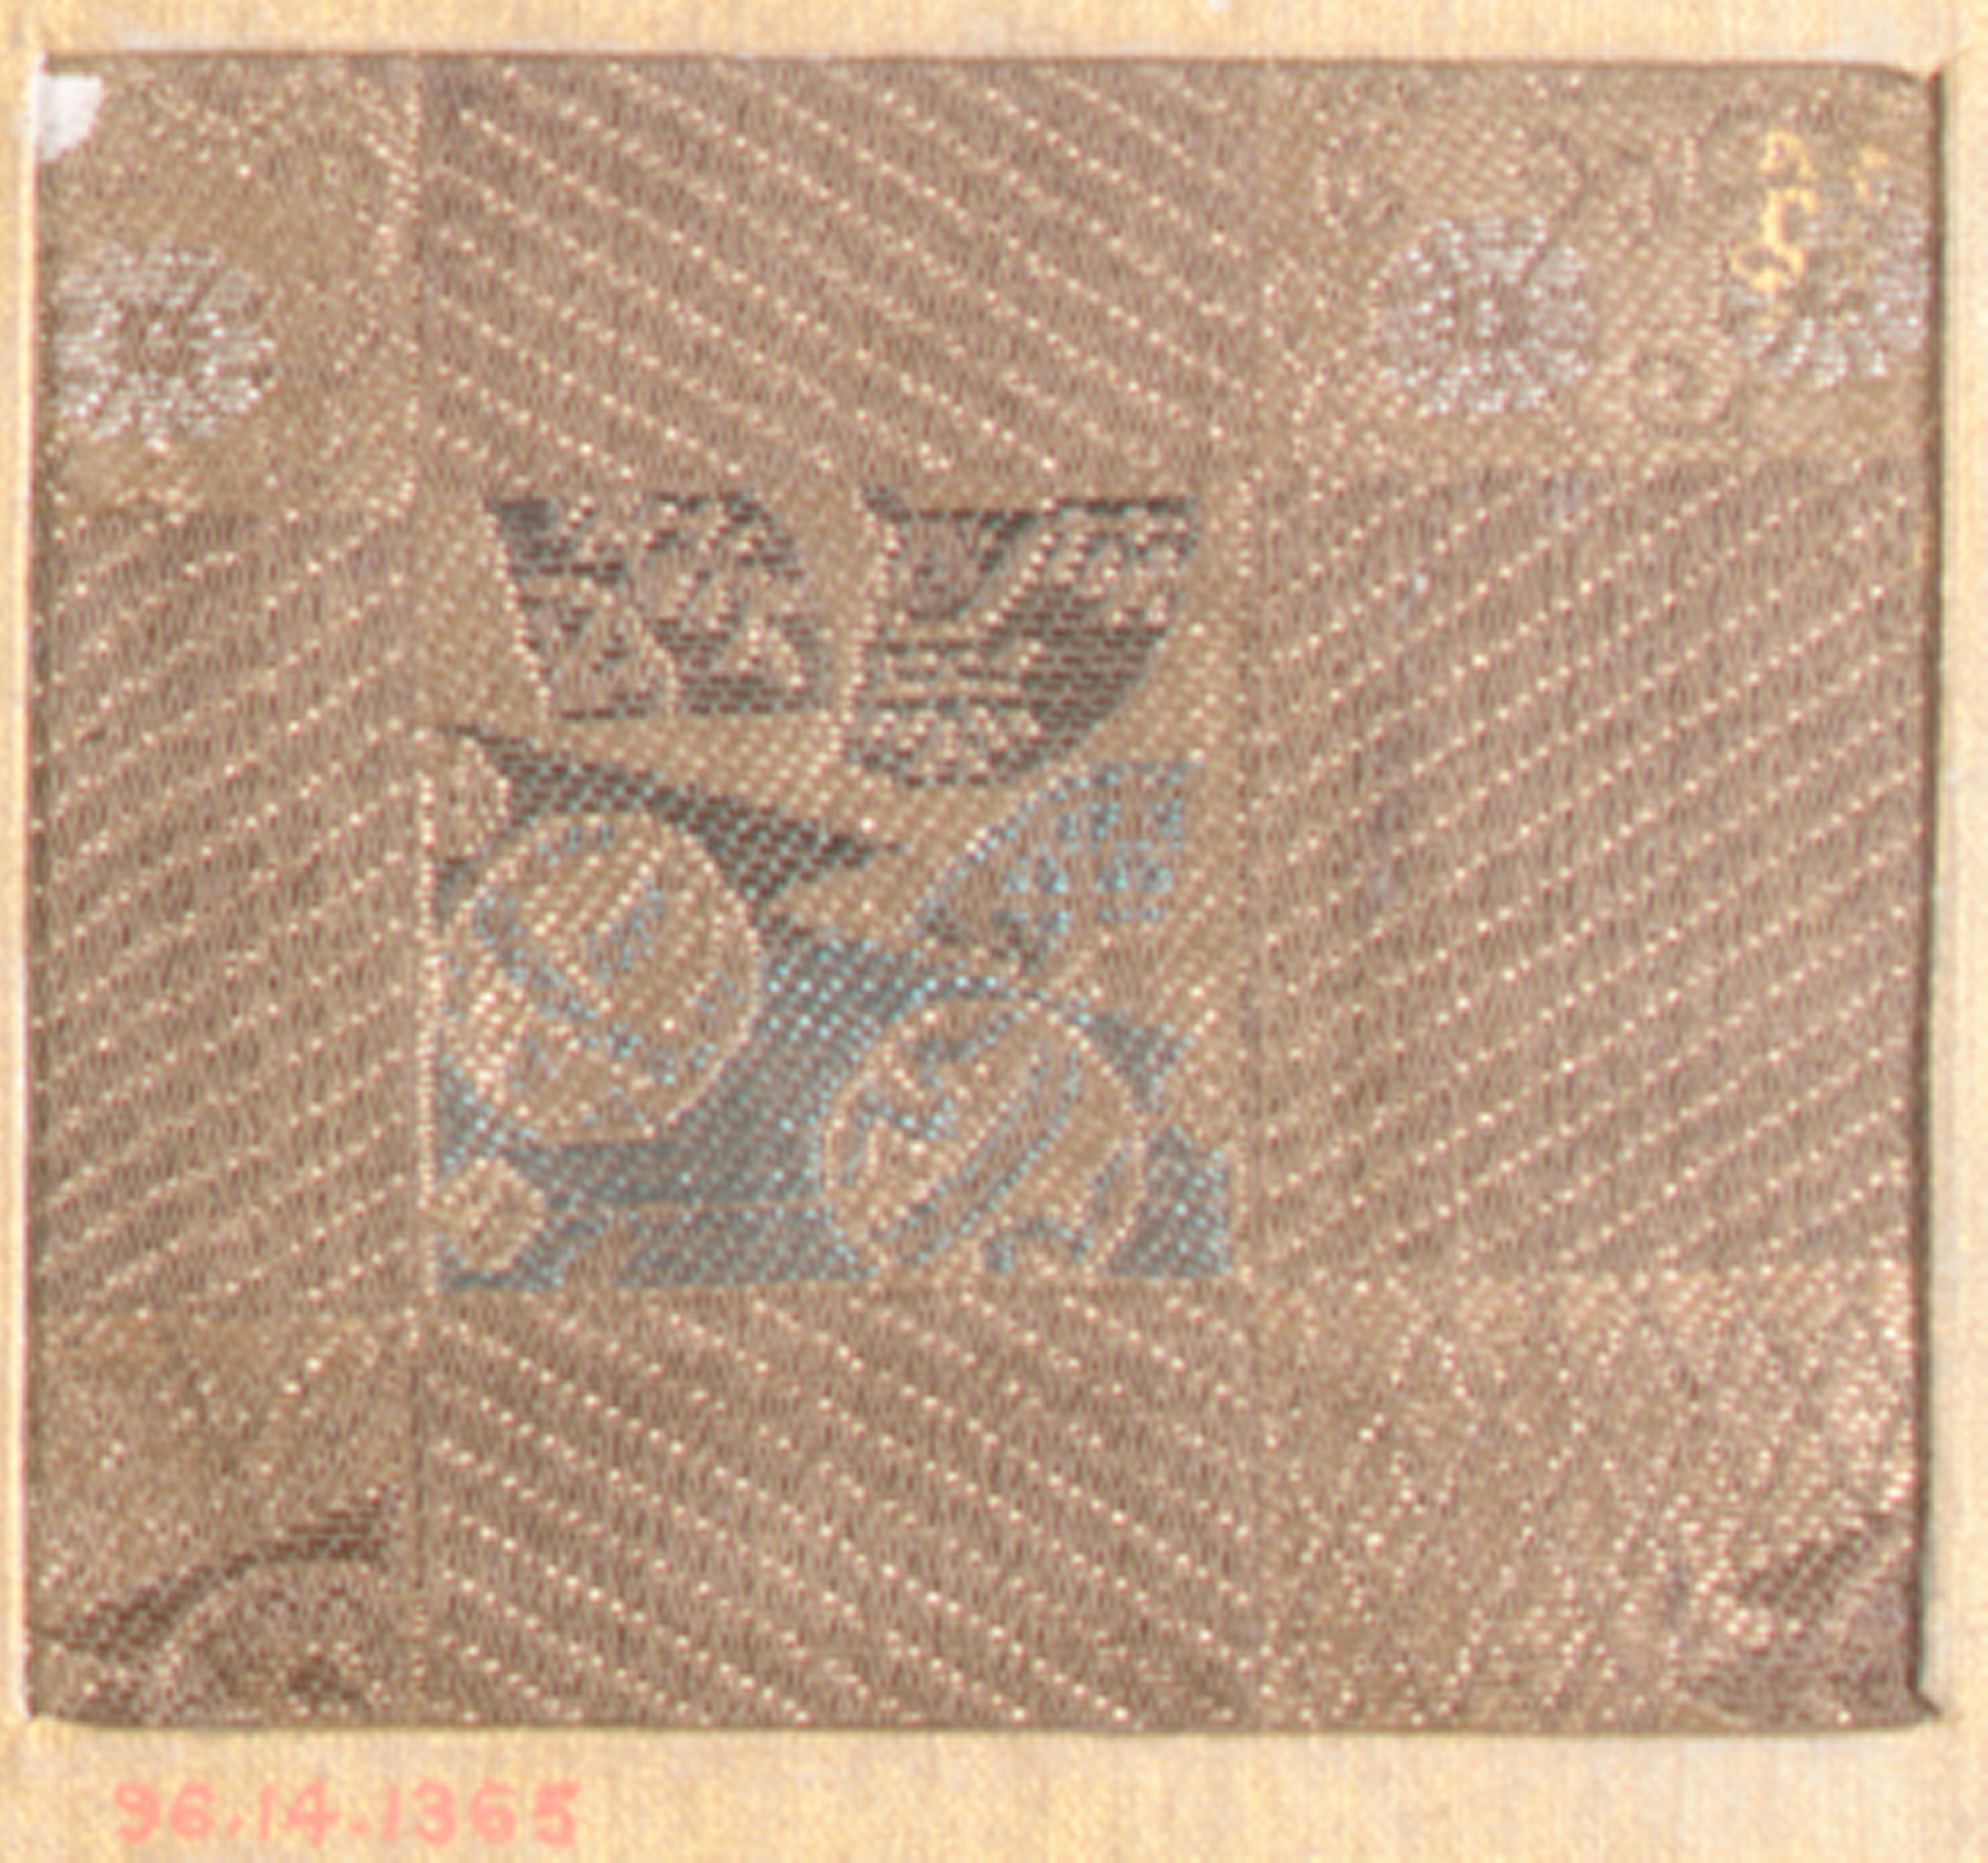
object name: piece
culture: japanese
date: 1701-1900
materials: silk